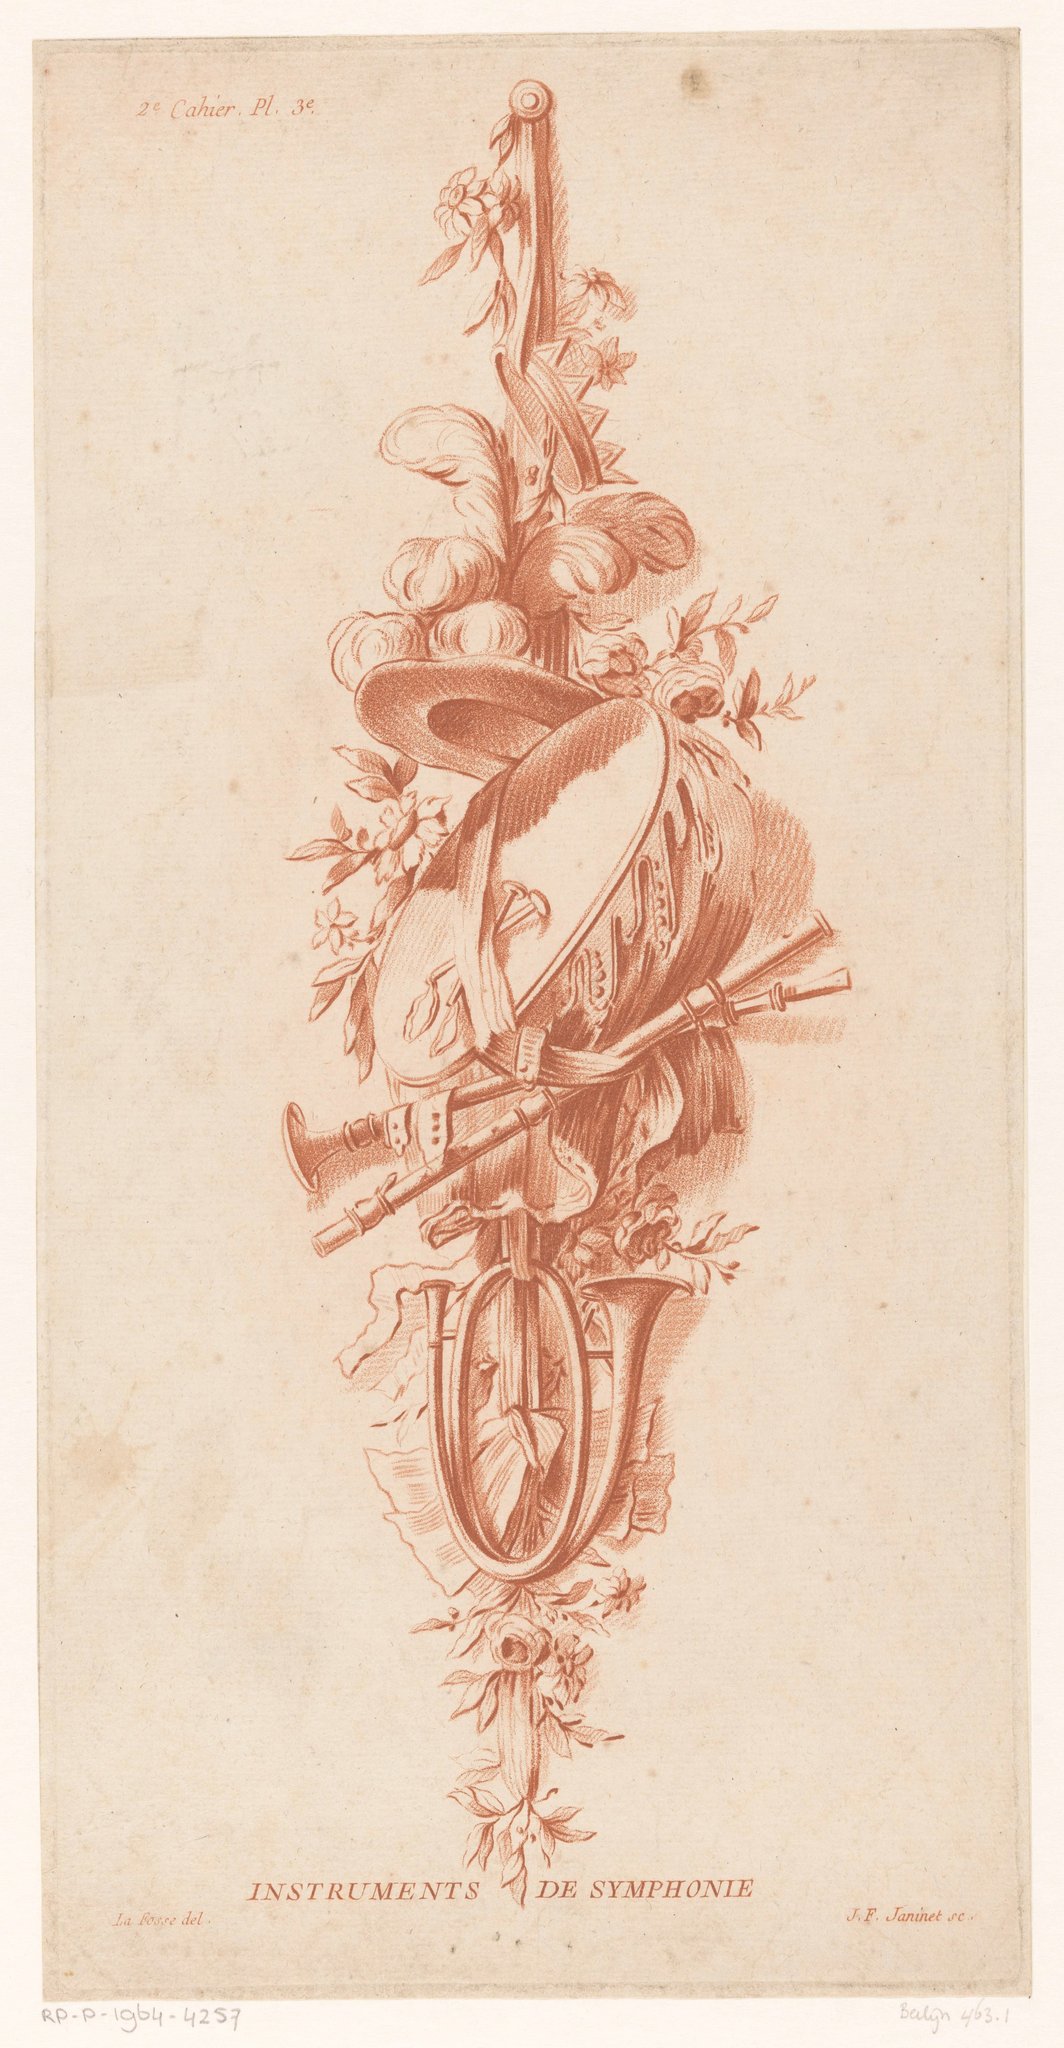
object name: print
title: 2e Cahier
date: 1772-1779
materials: paper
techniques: printmaking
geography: paris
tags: musical instruments; group of musical instruments, trophy, i.e.: decorative arrangement of symbolic or typical objects ~ ornament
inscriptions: collector's mark: Lugt 2760, collector's mark: Lugt 2228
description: Een trofee met een kroon, een hoed met veren, een trommel, klarinetten en een hoorn.